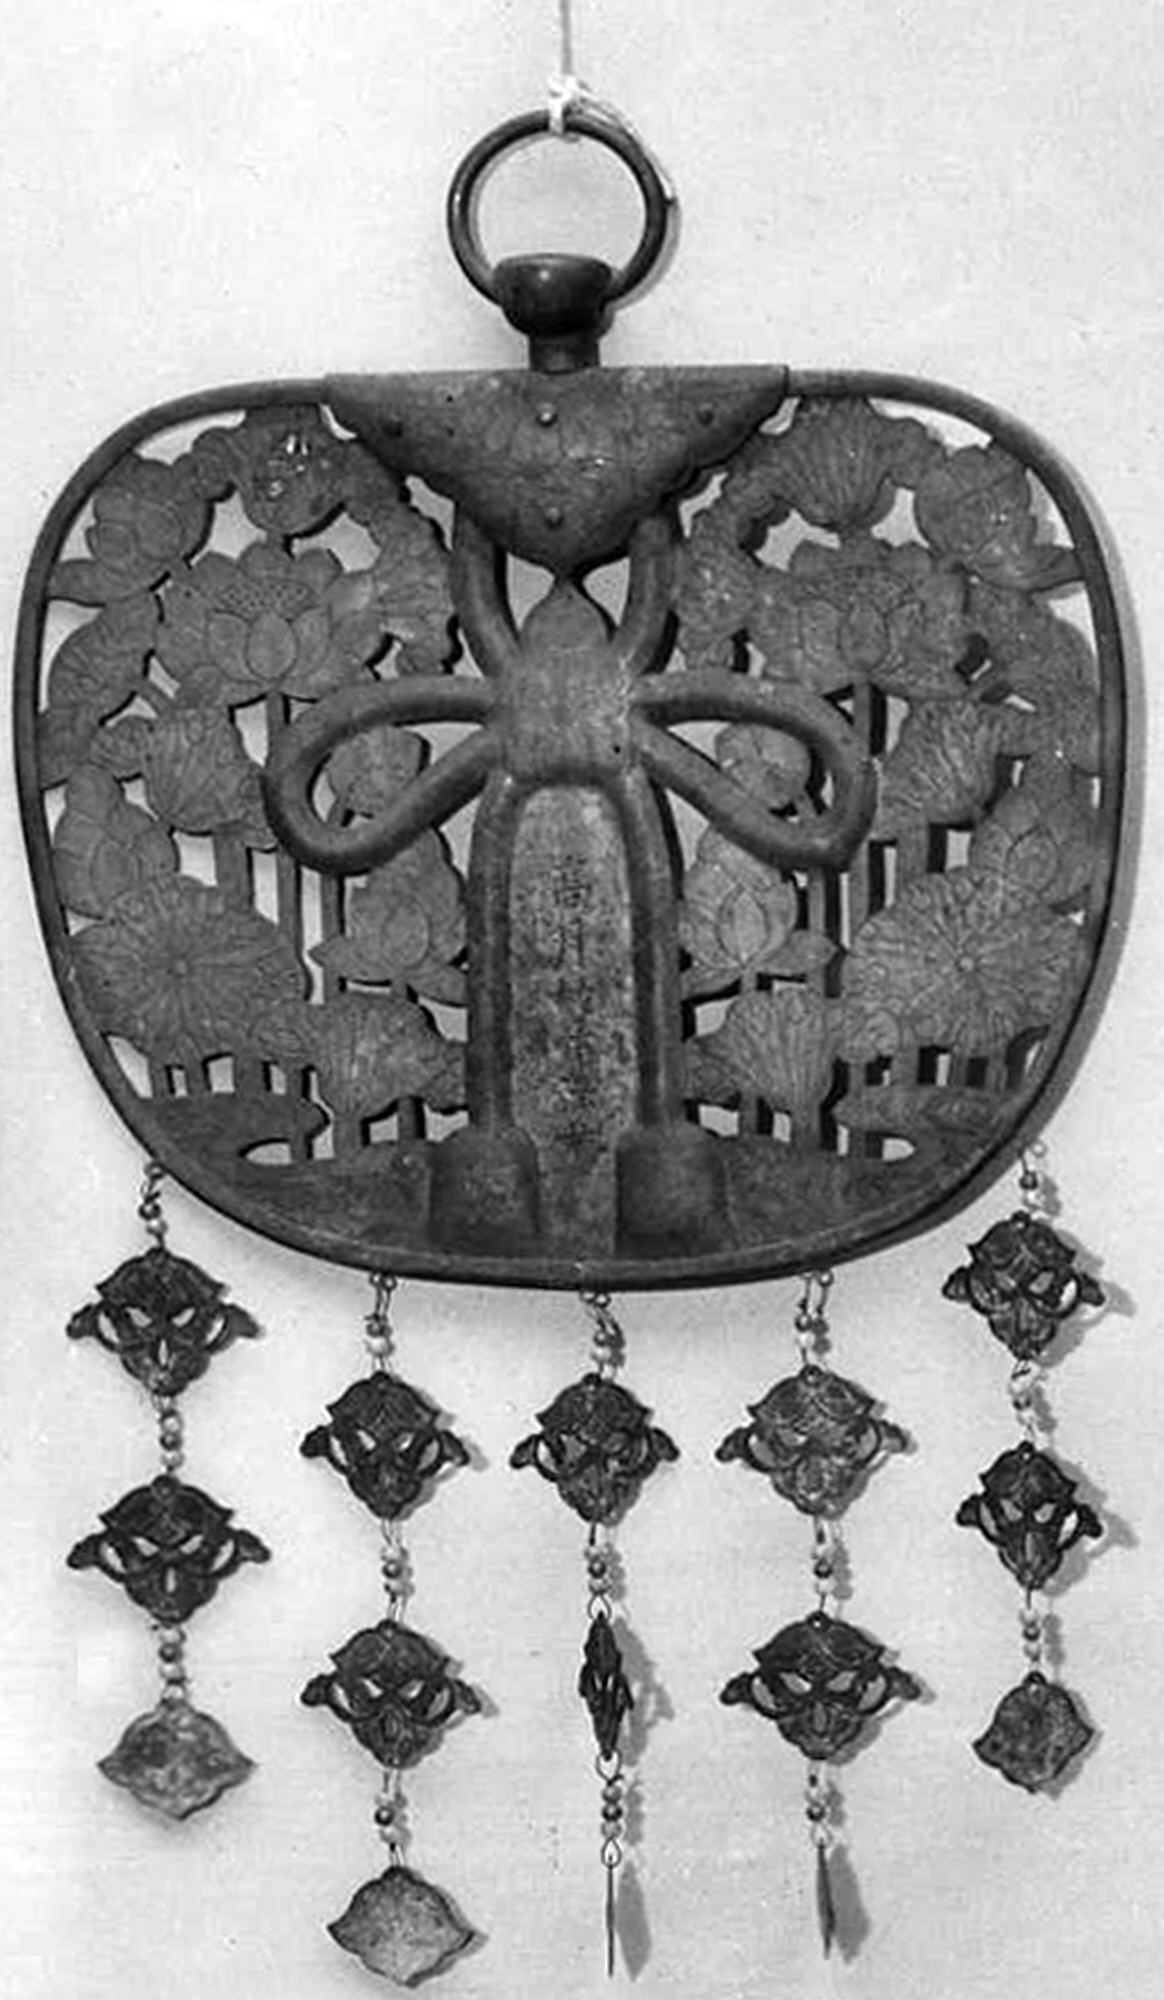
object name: temple decoration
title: Keman (“Flower Garland” Temple Decoration)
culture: japanese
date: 1725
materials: bronze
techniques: gilding